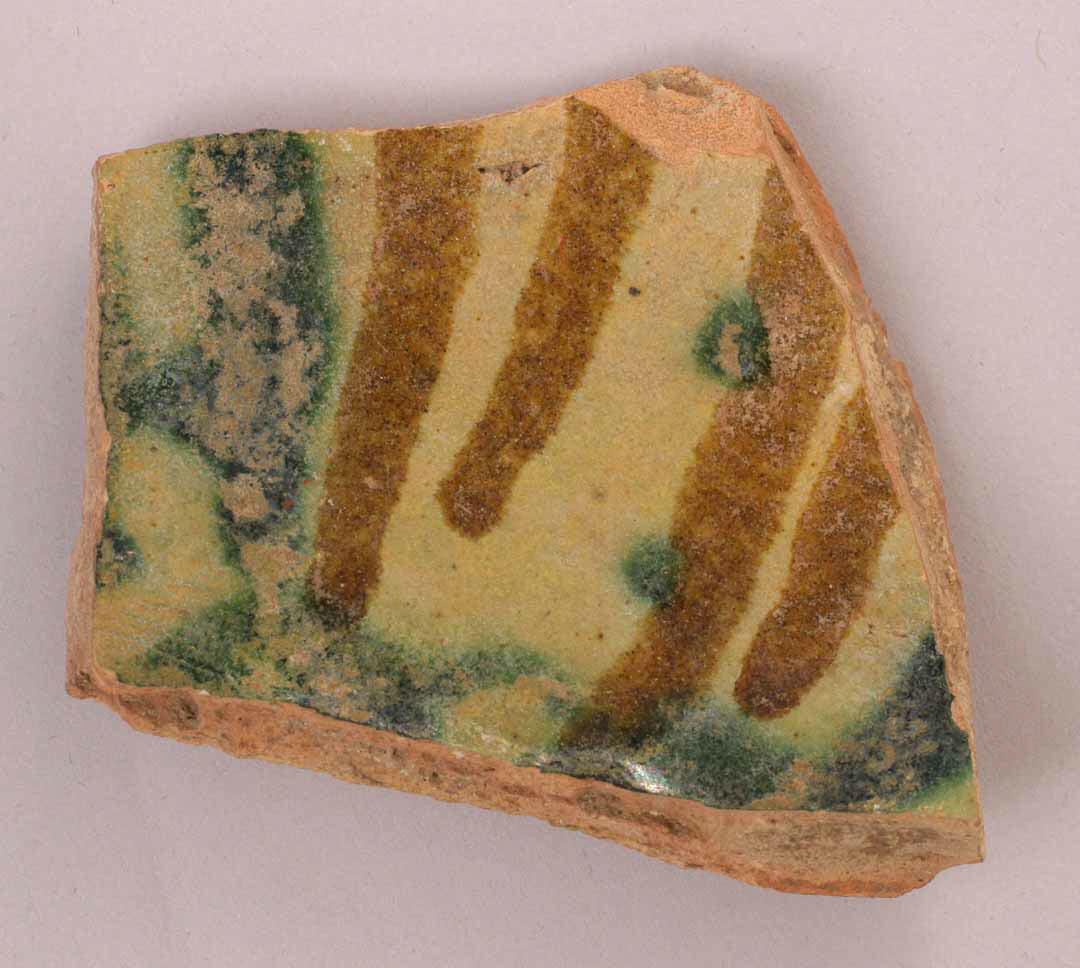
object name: fragment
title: Ceramic Fragment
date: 701-900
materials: earthenware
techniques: glazing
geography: iraq